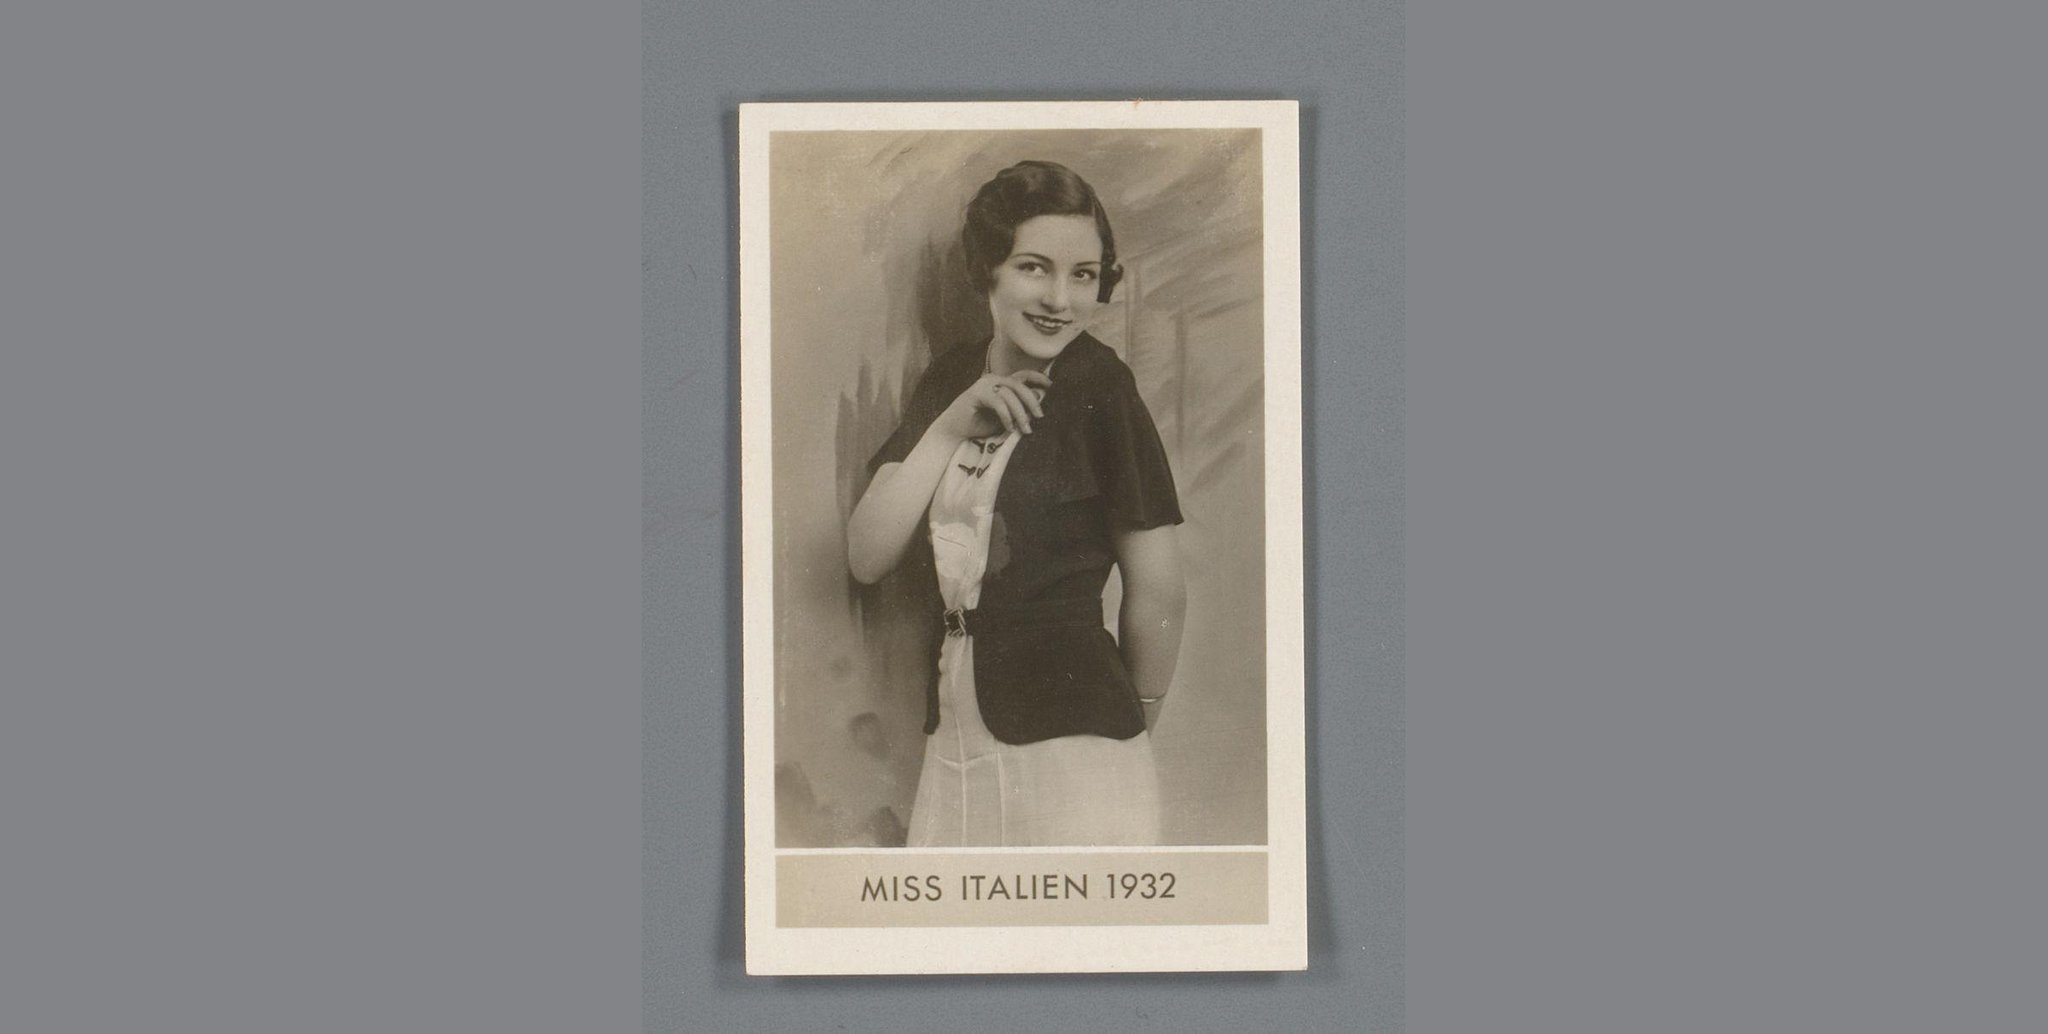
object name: photograph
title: Miss Italien 1932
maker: Anonymous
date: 1932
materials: paper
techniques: gelatin silver print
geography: dresden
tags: historical persons - bb - woman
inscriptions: inscription: ‘Die schönsten/ Frauen der Welt/ dargestellt durch die Schön-/ heitsköniginnen aller Länder,/ finden Sie in 190 echten/ Bromsilber-Fotos, die nur den/ CLUB-und-LIGA-Packun-/ gen beiliegen. Eind prächtiges/ Sammel-Album erhalten Sie/ für 75 Pfennig vom Händler/ oder bei Einsendung von/ 75 Pfennig in Briefmarken/ von der Bilderstelle Lohse,/ Dresden A24, Nossener Str. 1./ Ges. gesch. Nachdruck verboten!’